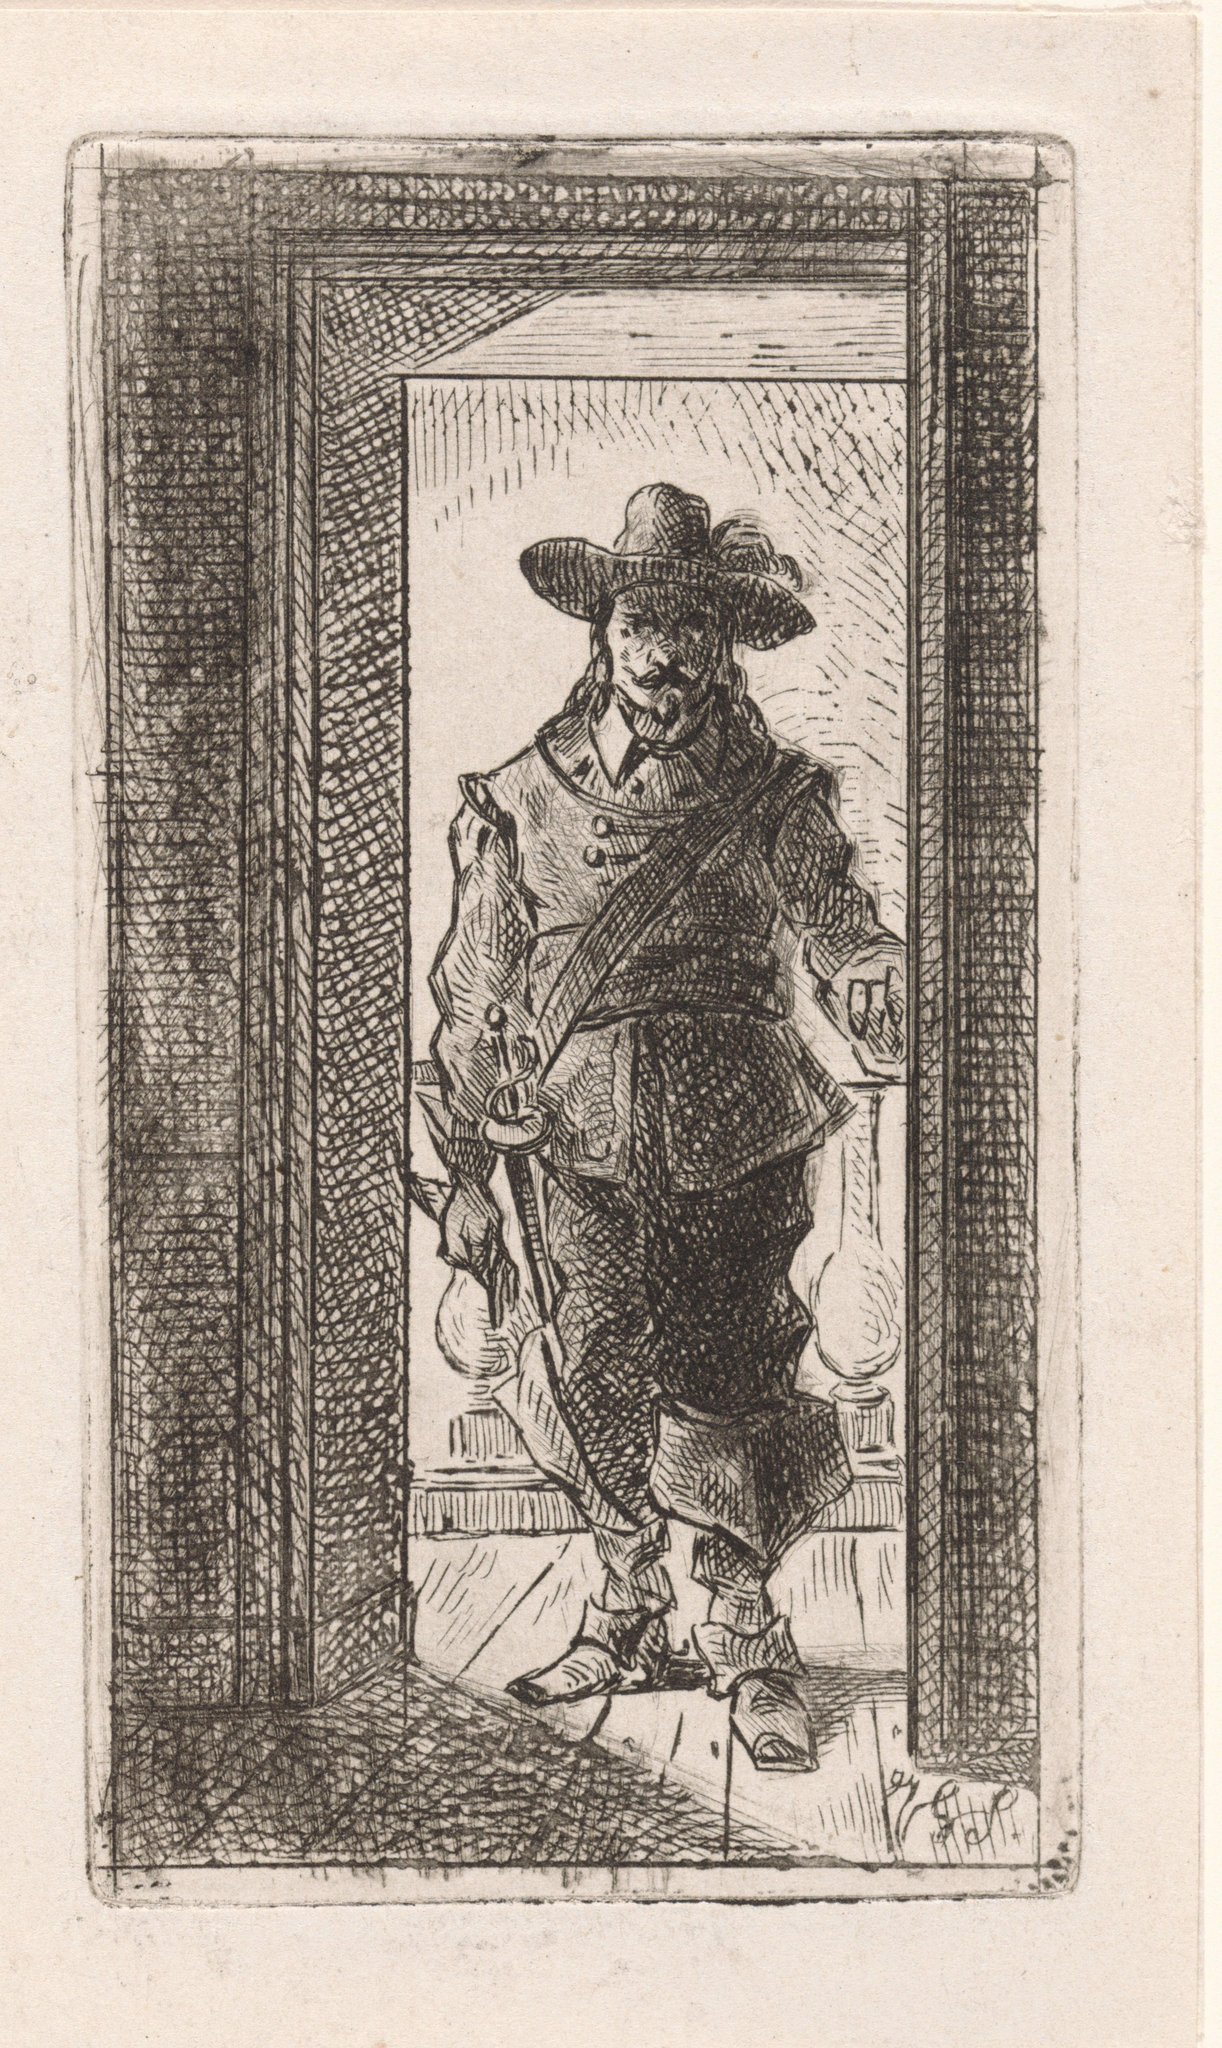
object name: print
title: Man in zeventiende eeuwse kledij, staand in een deuropening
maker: jan gerard smits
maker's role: draughtsman, print maker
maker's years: 1823-1910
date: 1838-1885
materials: paper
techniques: drypoint, etching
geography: the hague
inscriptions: collector's mark: Lugt 2228